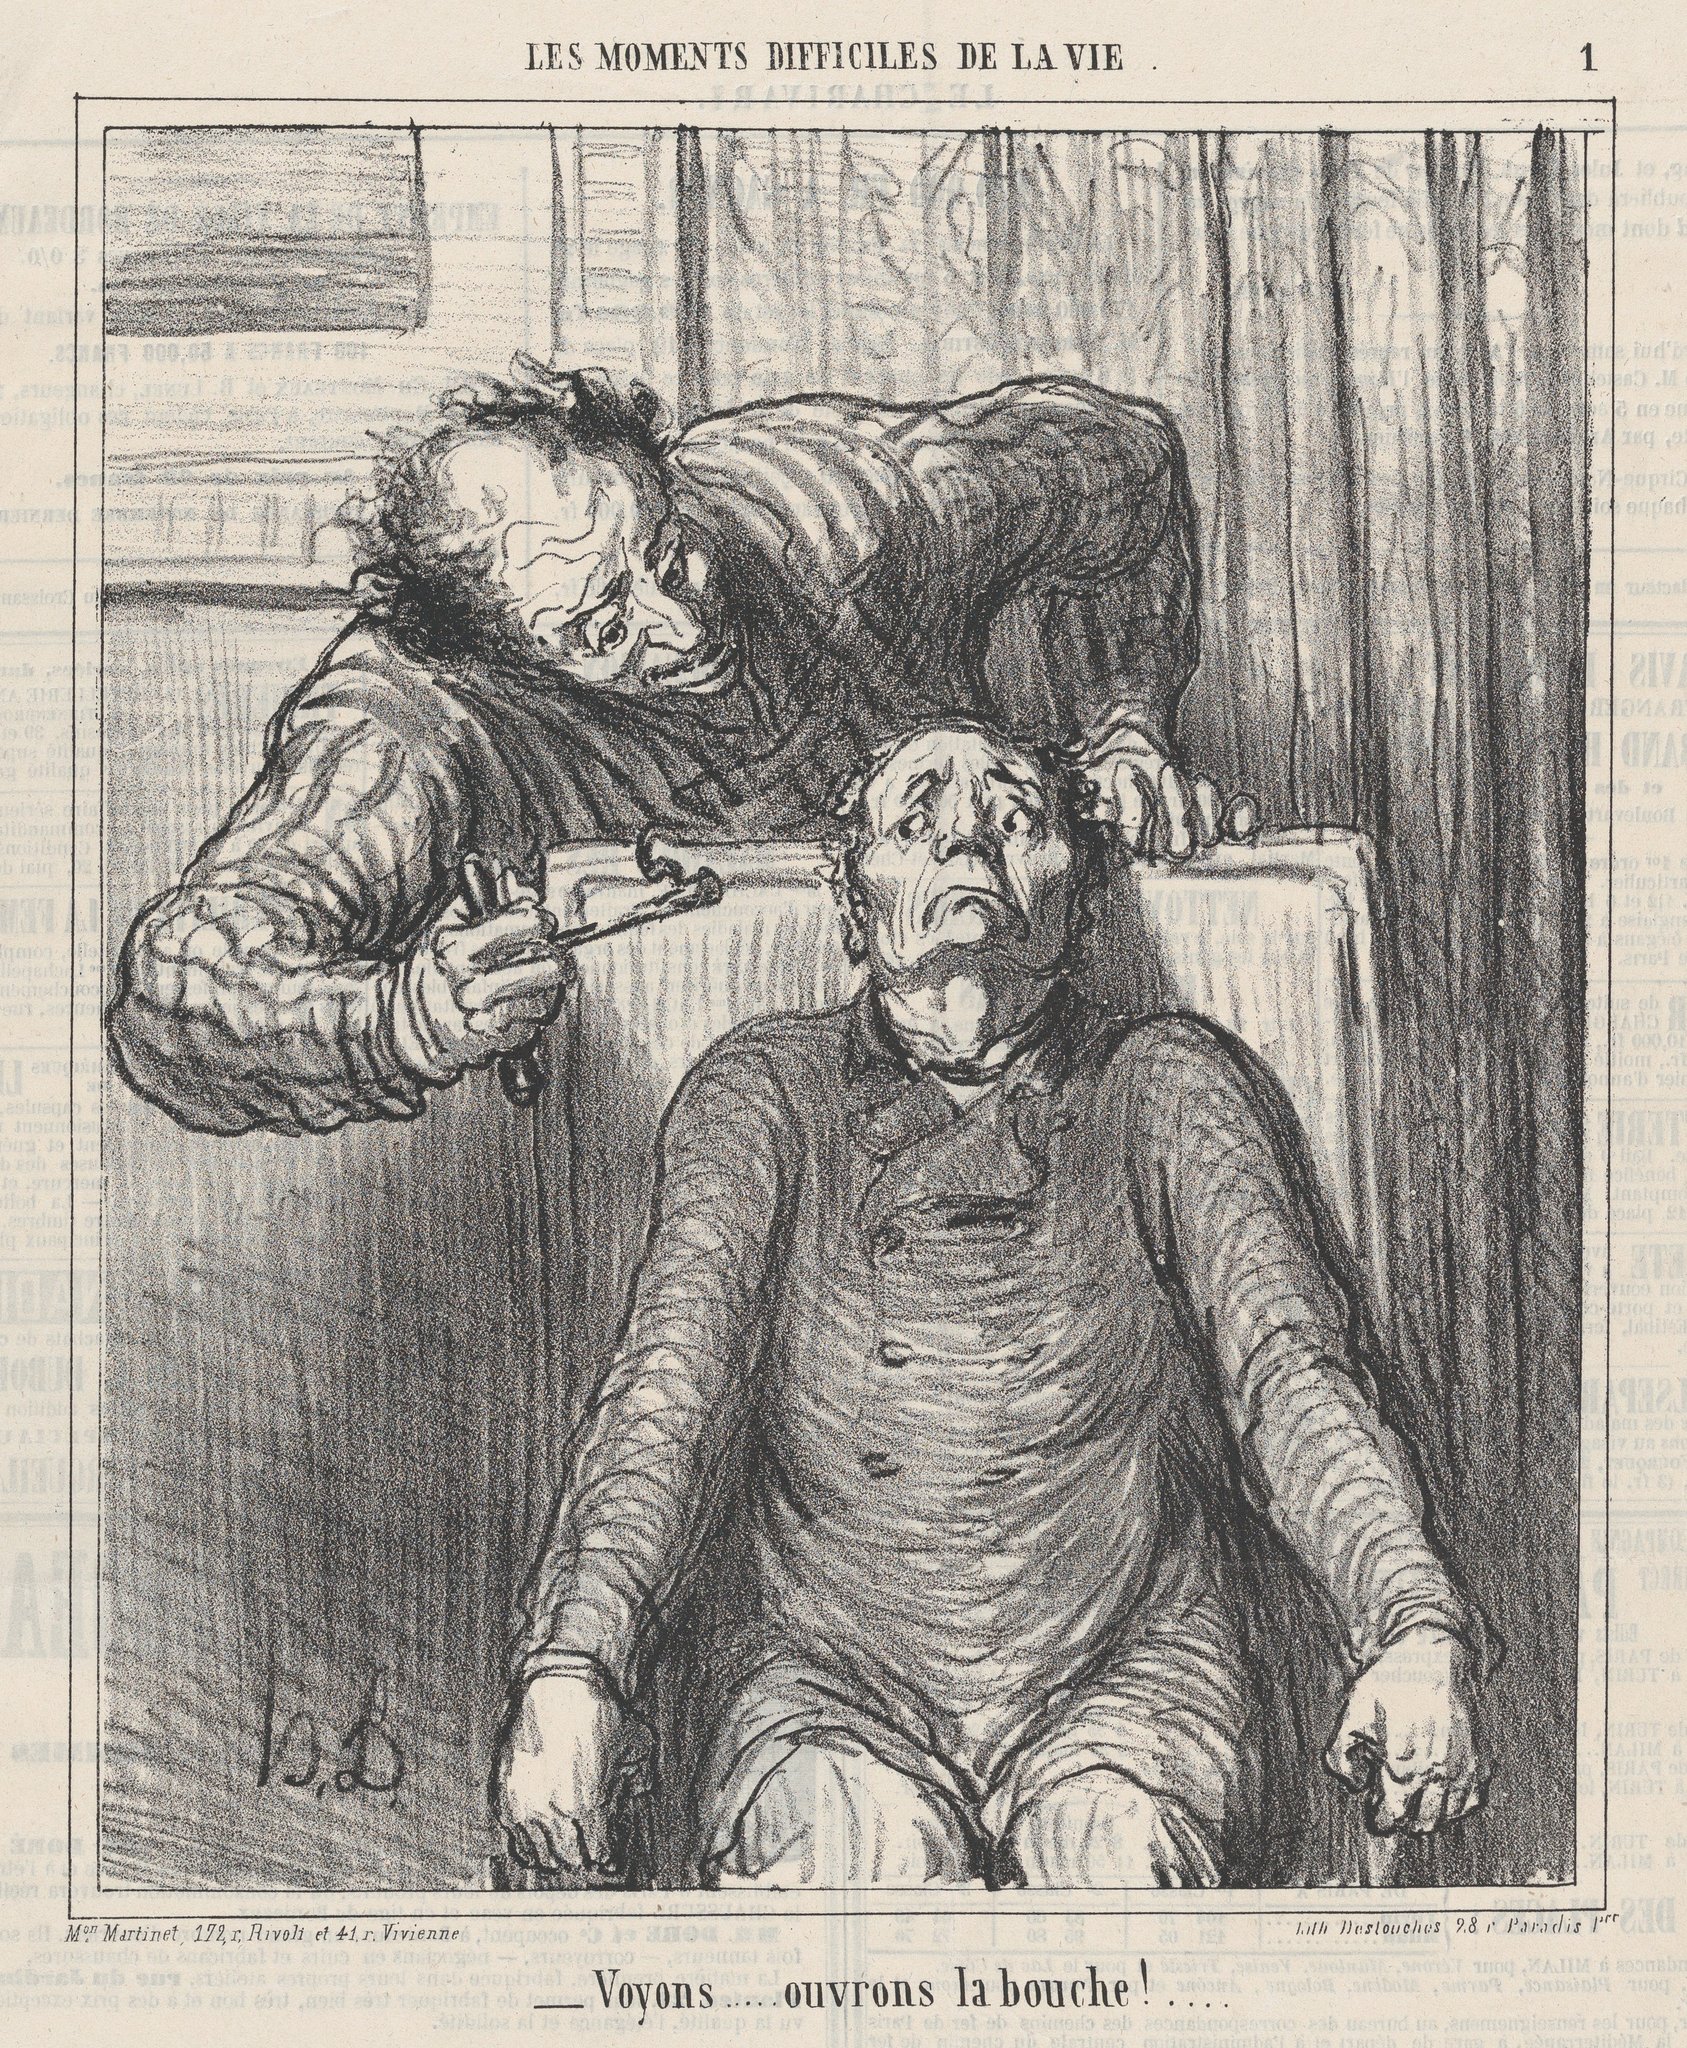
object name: print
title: Come on... open your mouth!..., from 'The difficult moments of life,' published in Le Charivari, March 12, 1864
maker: honoré daumier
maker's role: artist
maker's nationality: french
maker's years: 1808-1879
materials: paper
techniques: lithograph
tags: fear,men